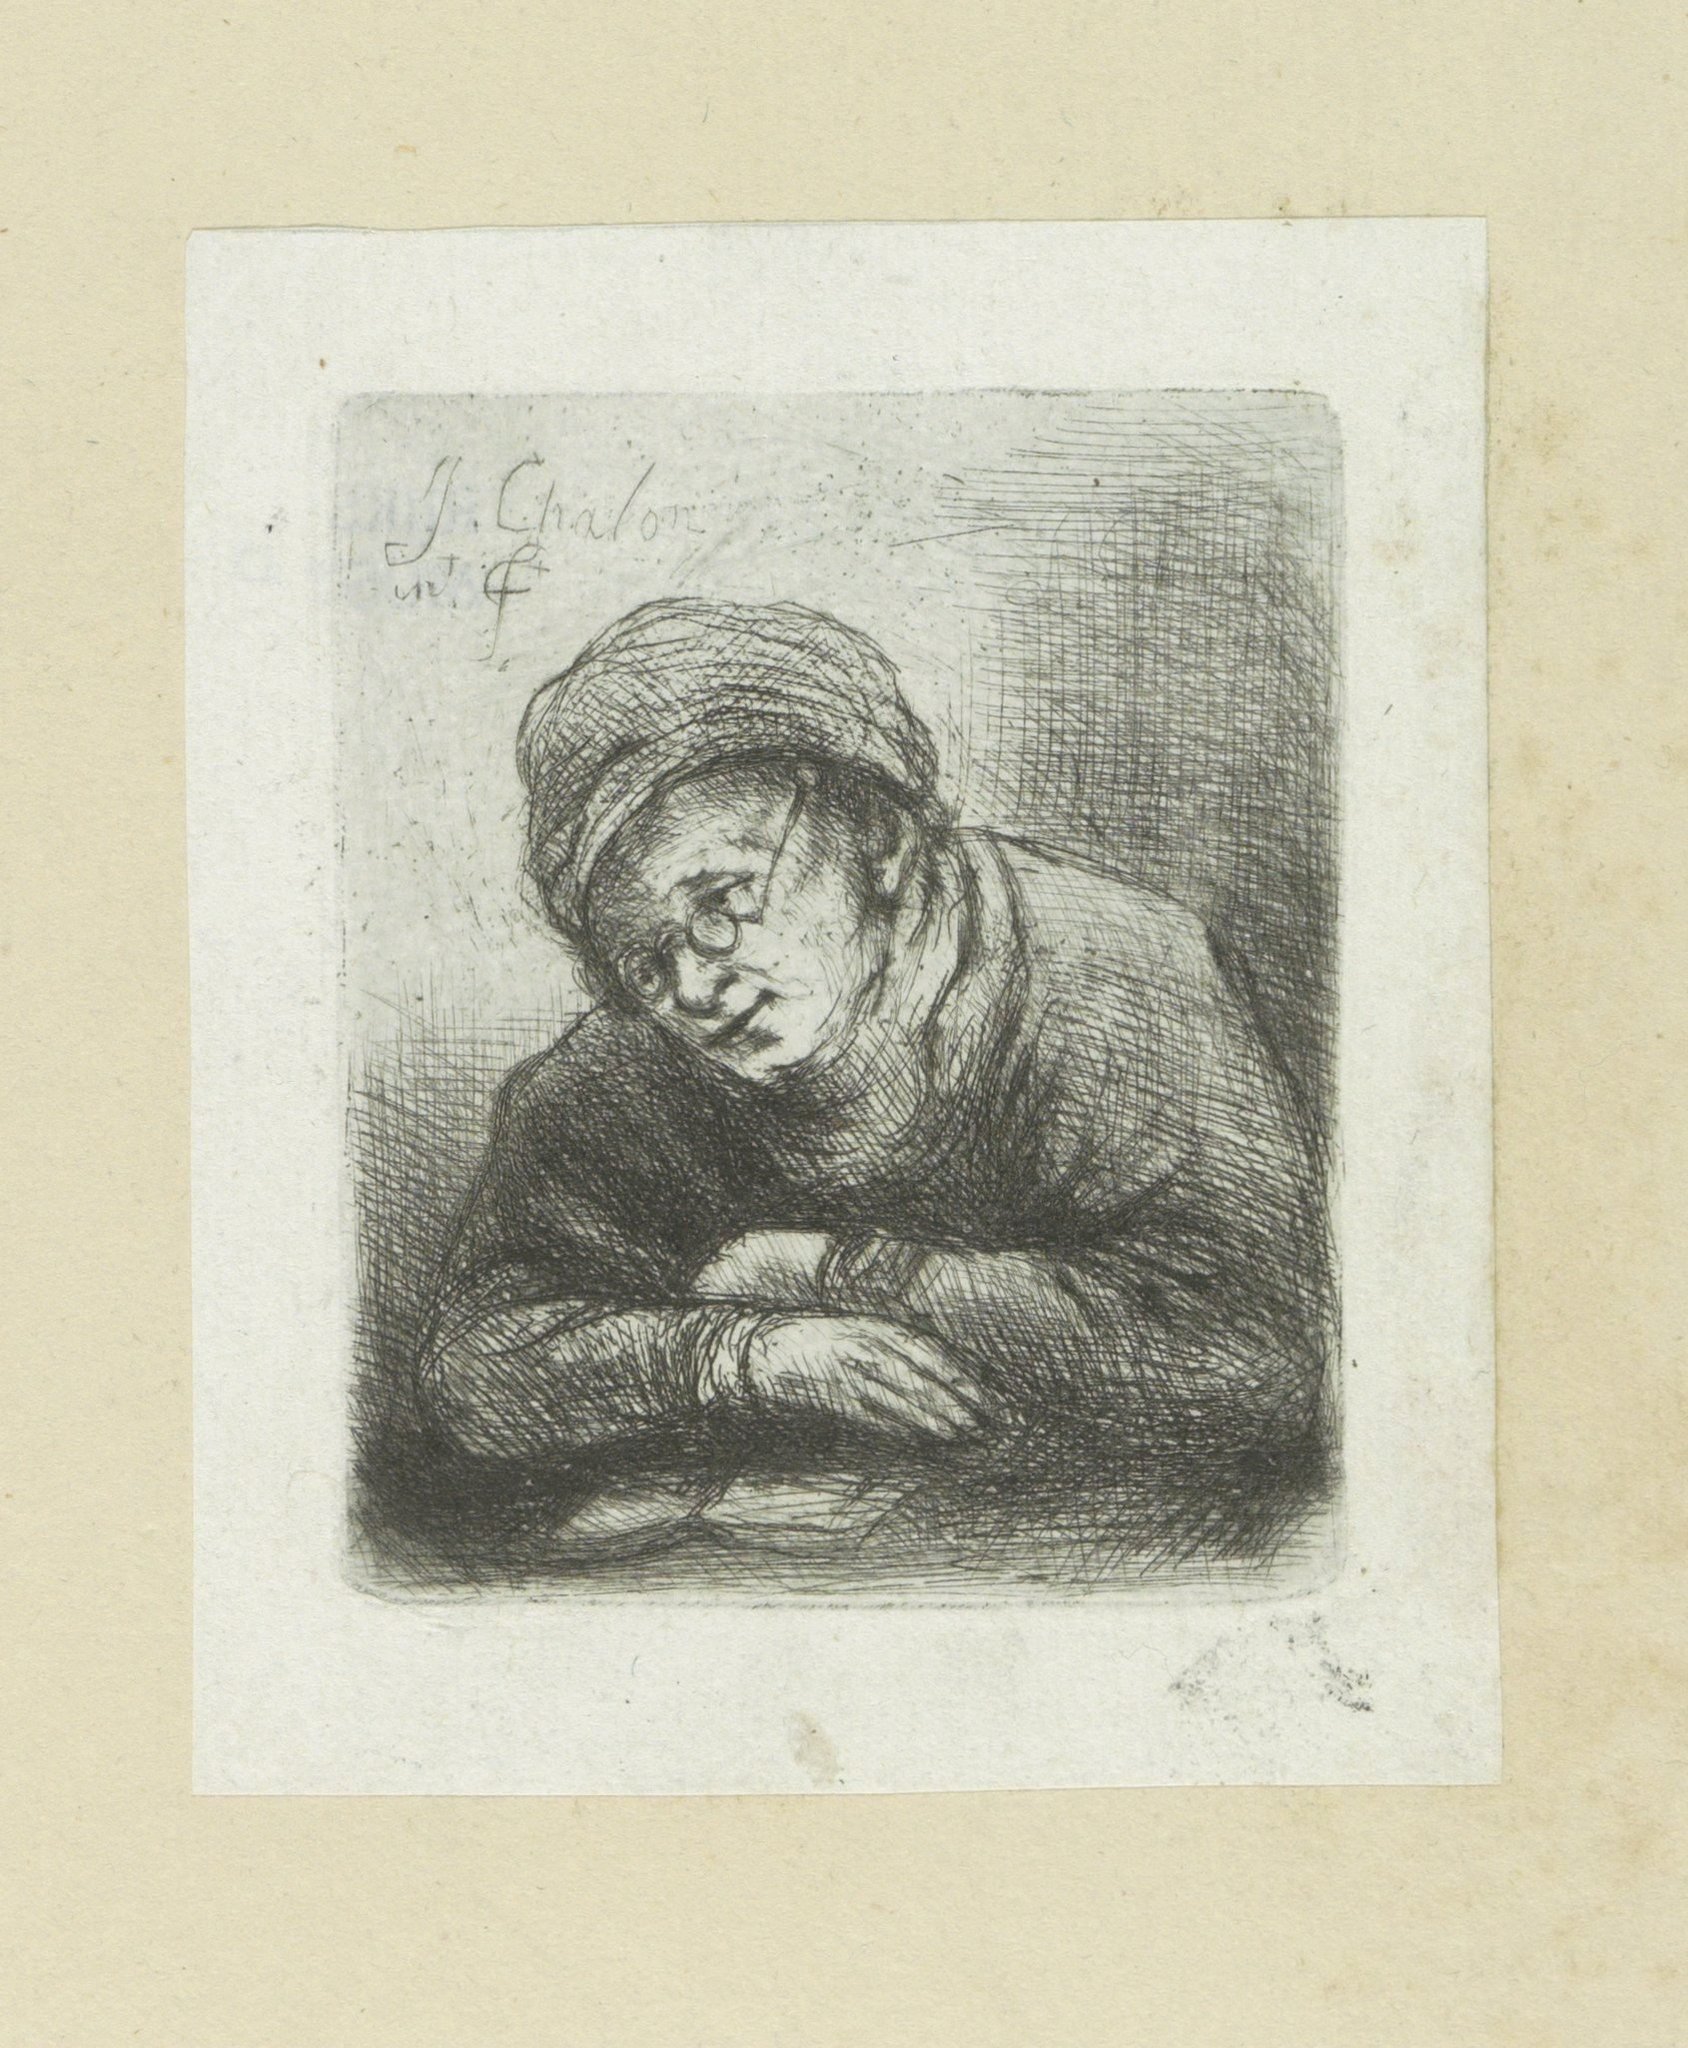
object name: print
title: The Compleat Work of Etchings by John Chalon / Oeuvre Complette des Eaux Fortes par Jean Chalon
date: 1802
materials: paper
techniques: drypoint, etching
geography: london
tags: eyeglasses, spectacles, reading, head-gear: cap (+ men's clothes), morphology of human expression (+ adult female (human being))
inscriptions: collector's mark: ‘RIJKS / MUSM’, collector's mark: ‘B’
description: Een volwassen man met een bril en een muts. Hij leest een boek. De prent maakt deel uit van een album.